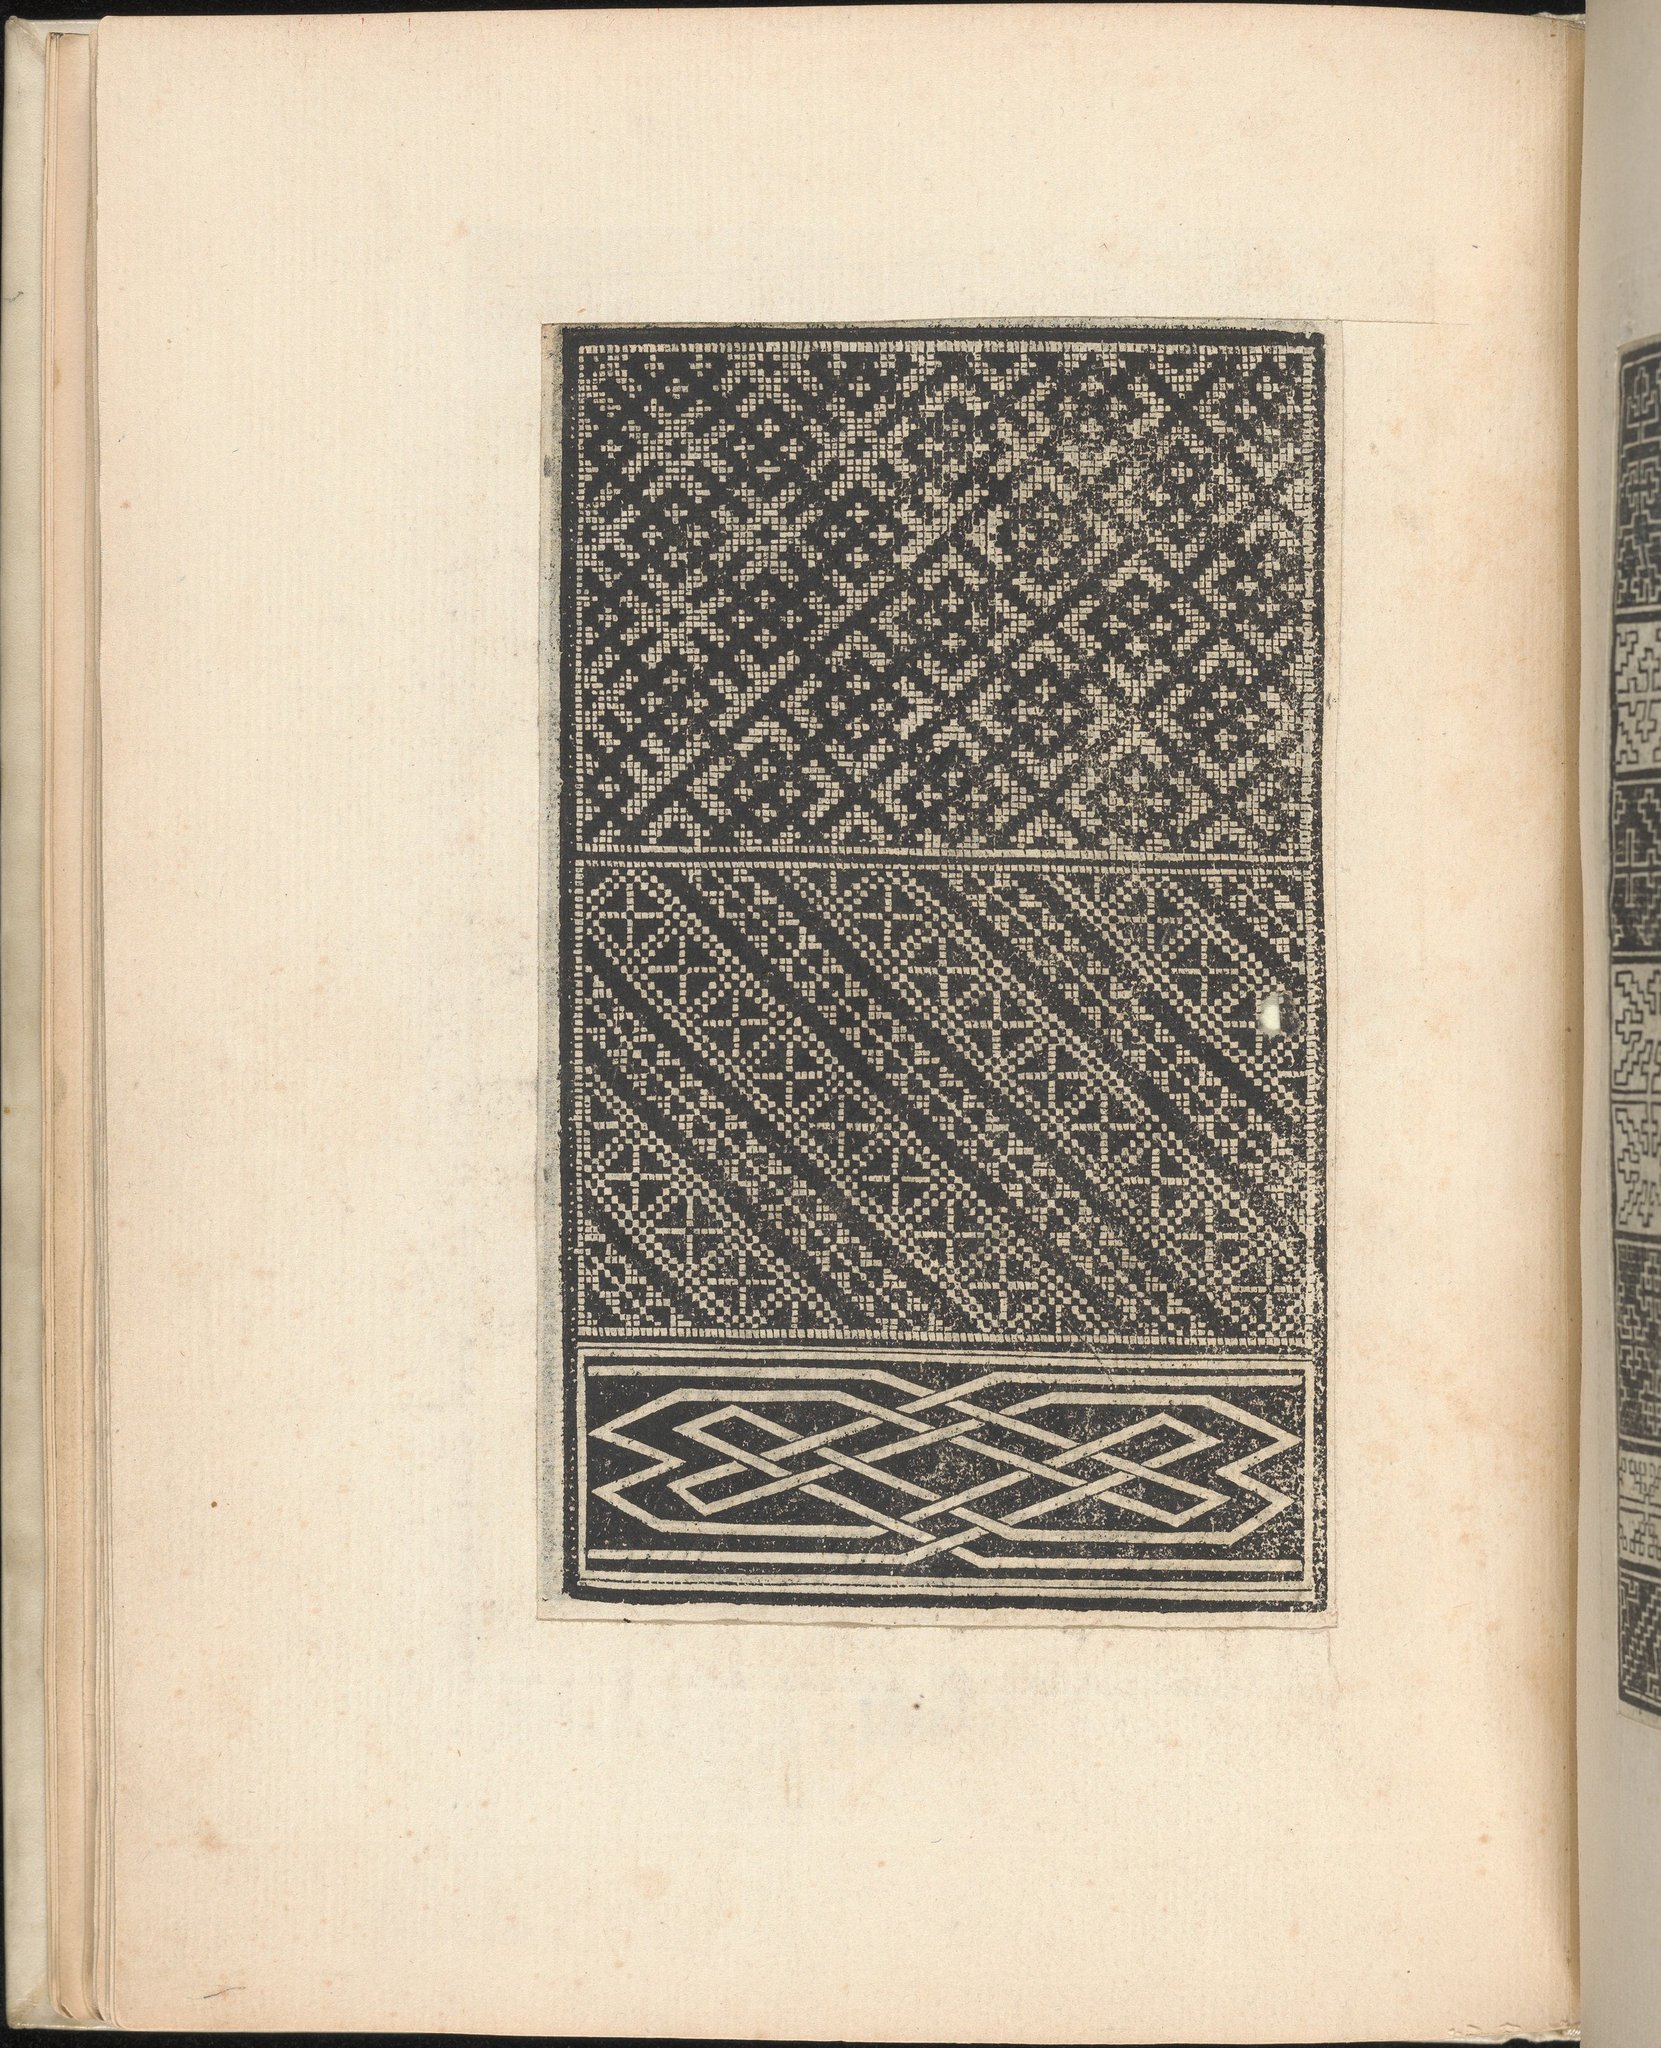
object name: book print ornament architecture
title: Esemplario di lavori, page 9 (verso)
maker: nicolò zoppino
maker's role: publisher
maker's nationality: italian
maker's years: 1478-1544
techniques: bookbinding, inlay, woodcut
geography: italy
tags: ornament